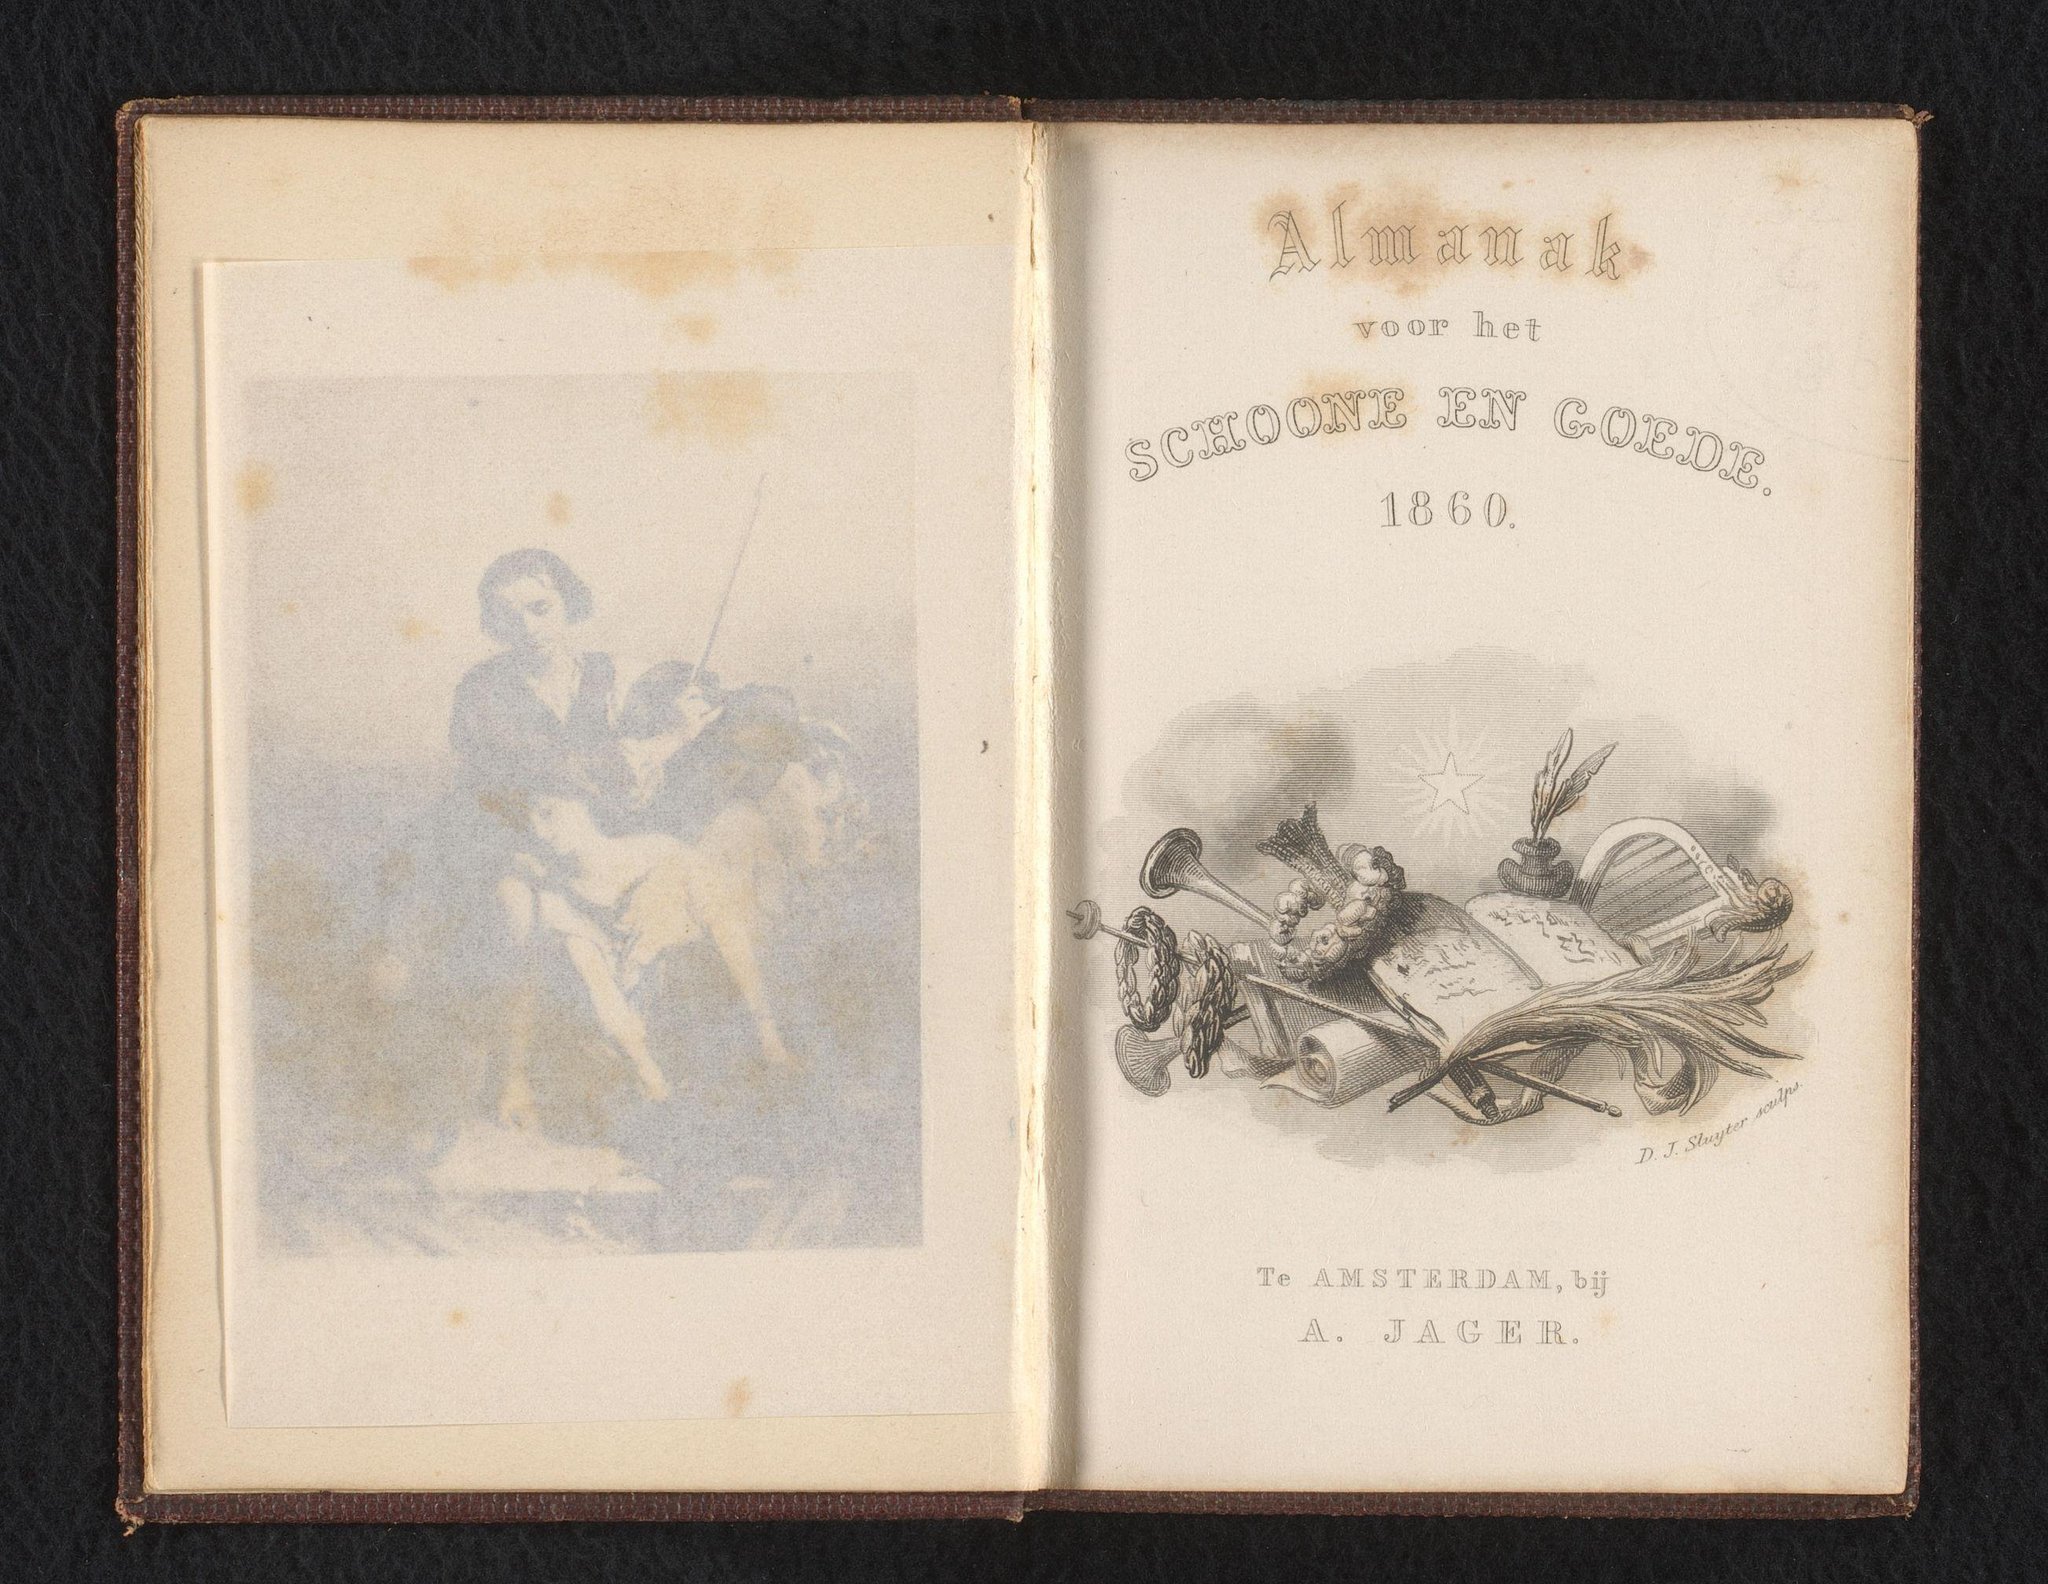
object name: book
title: Almanak voor het schoone en goede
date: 1860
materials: cardboard, paper, textile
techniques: albumen print, engraving, printing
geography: amsterdam